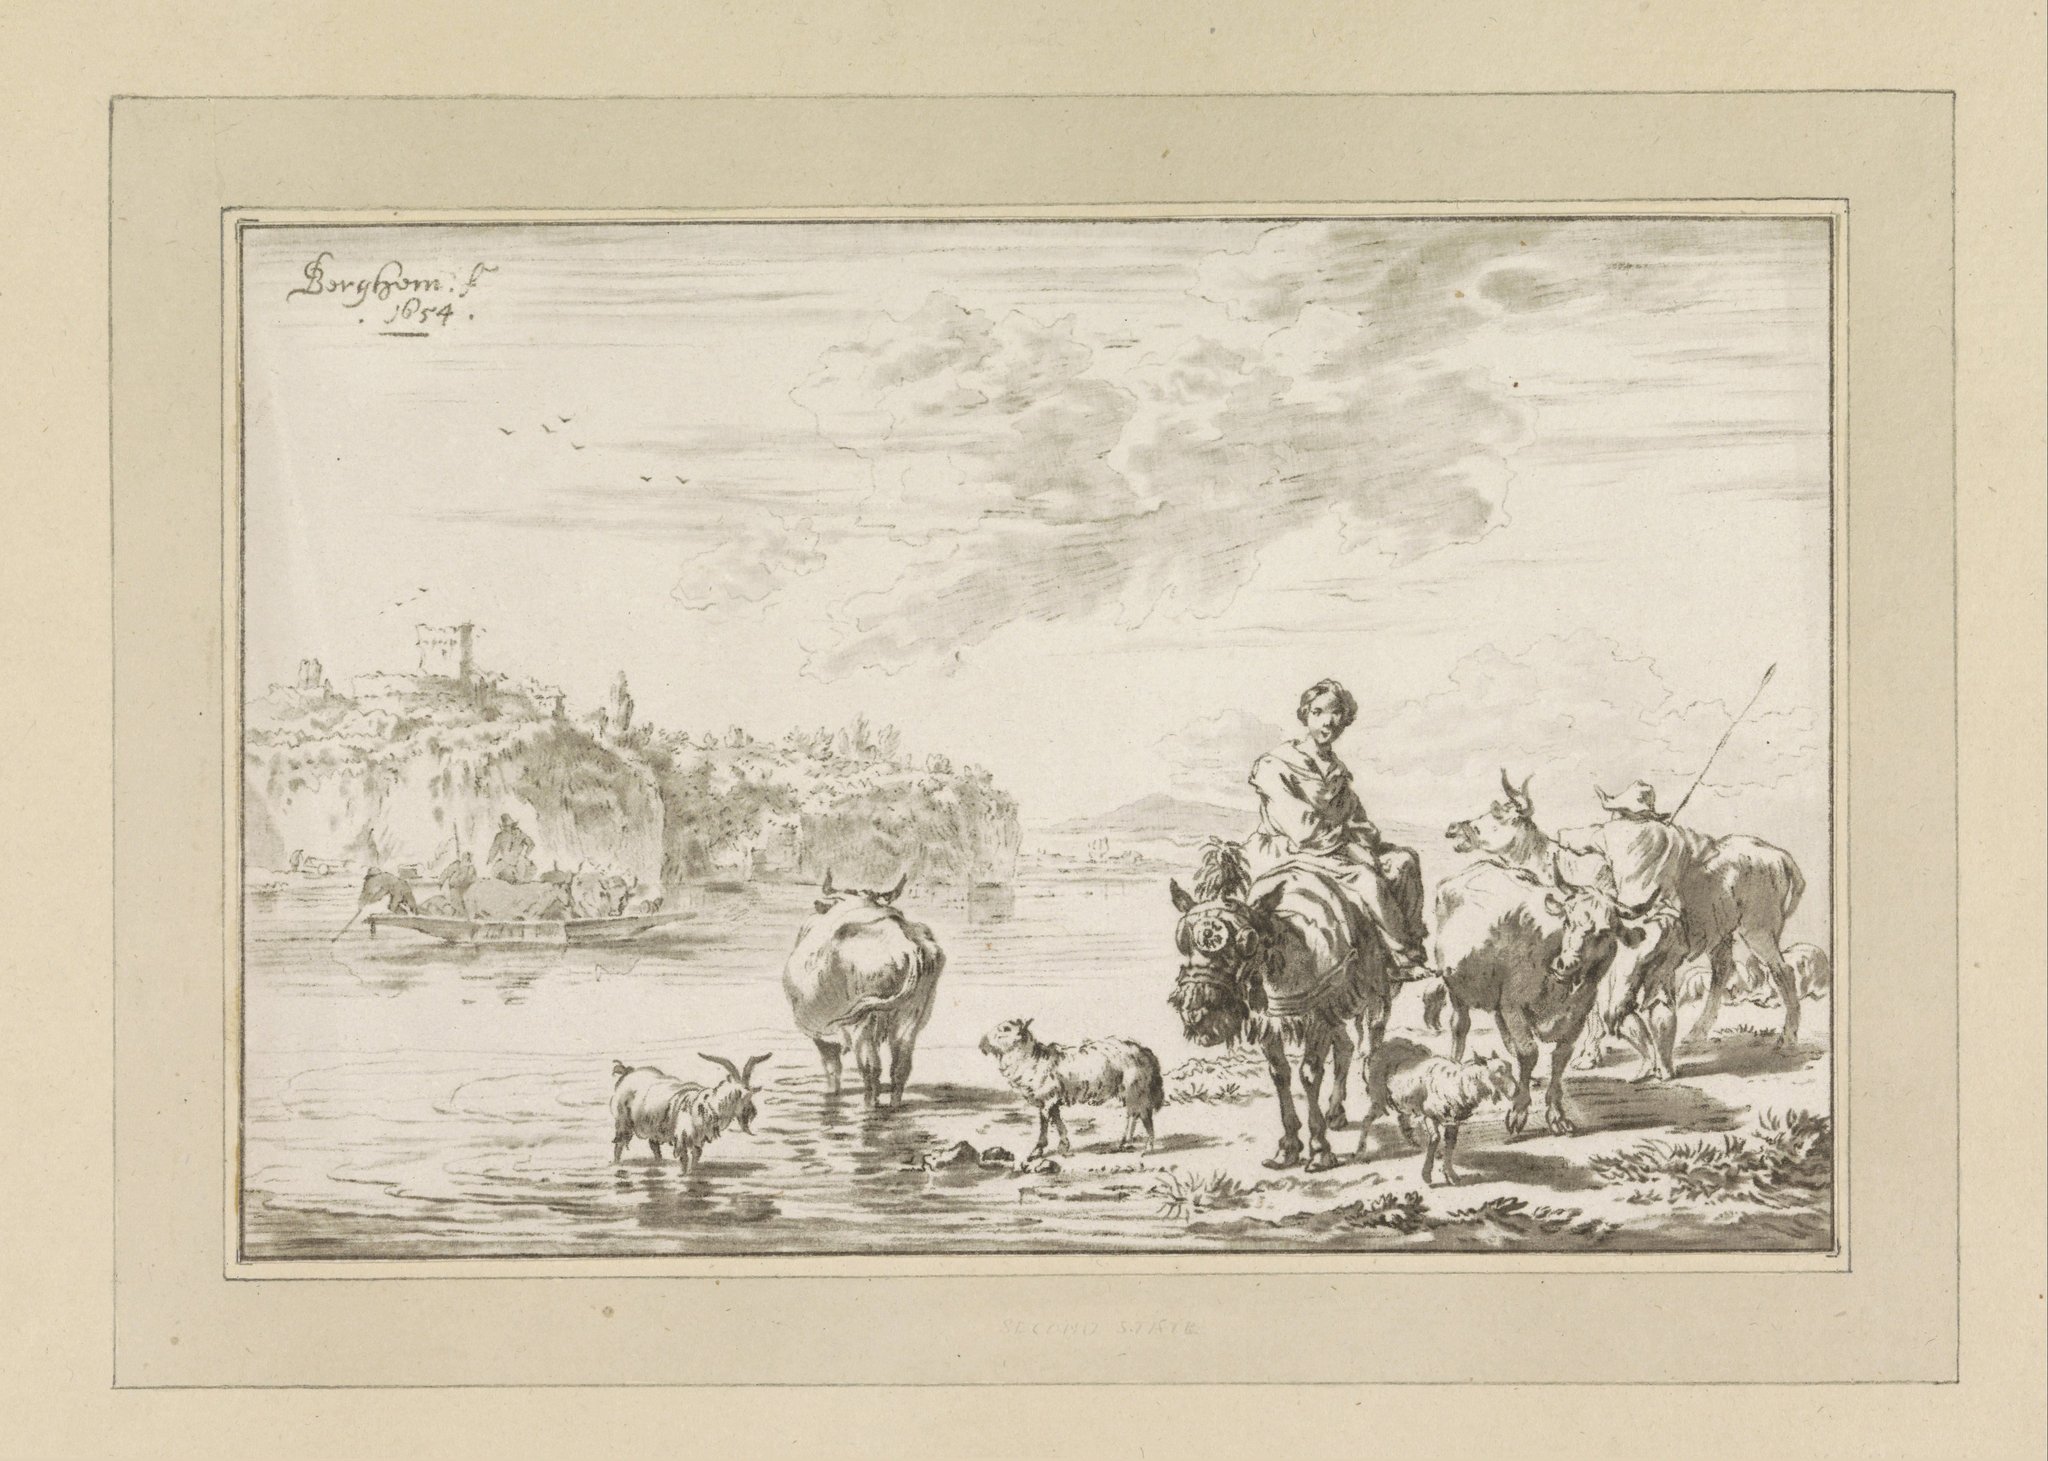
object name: print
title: Vrouw op muilezel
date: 1769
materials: paper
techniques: printmaking, etching, roulette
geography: amsterdam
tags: ass, donkey, river, cattle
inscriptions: collector's mark: Lugt 2228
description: Een vrouw rijdt op een muilezel langs een rivier. Naast de ezel staan koeien, schapen en een geit. Op het water een schuit.